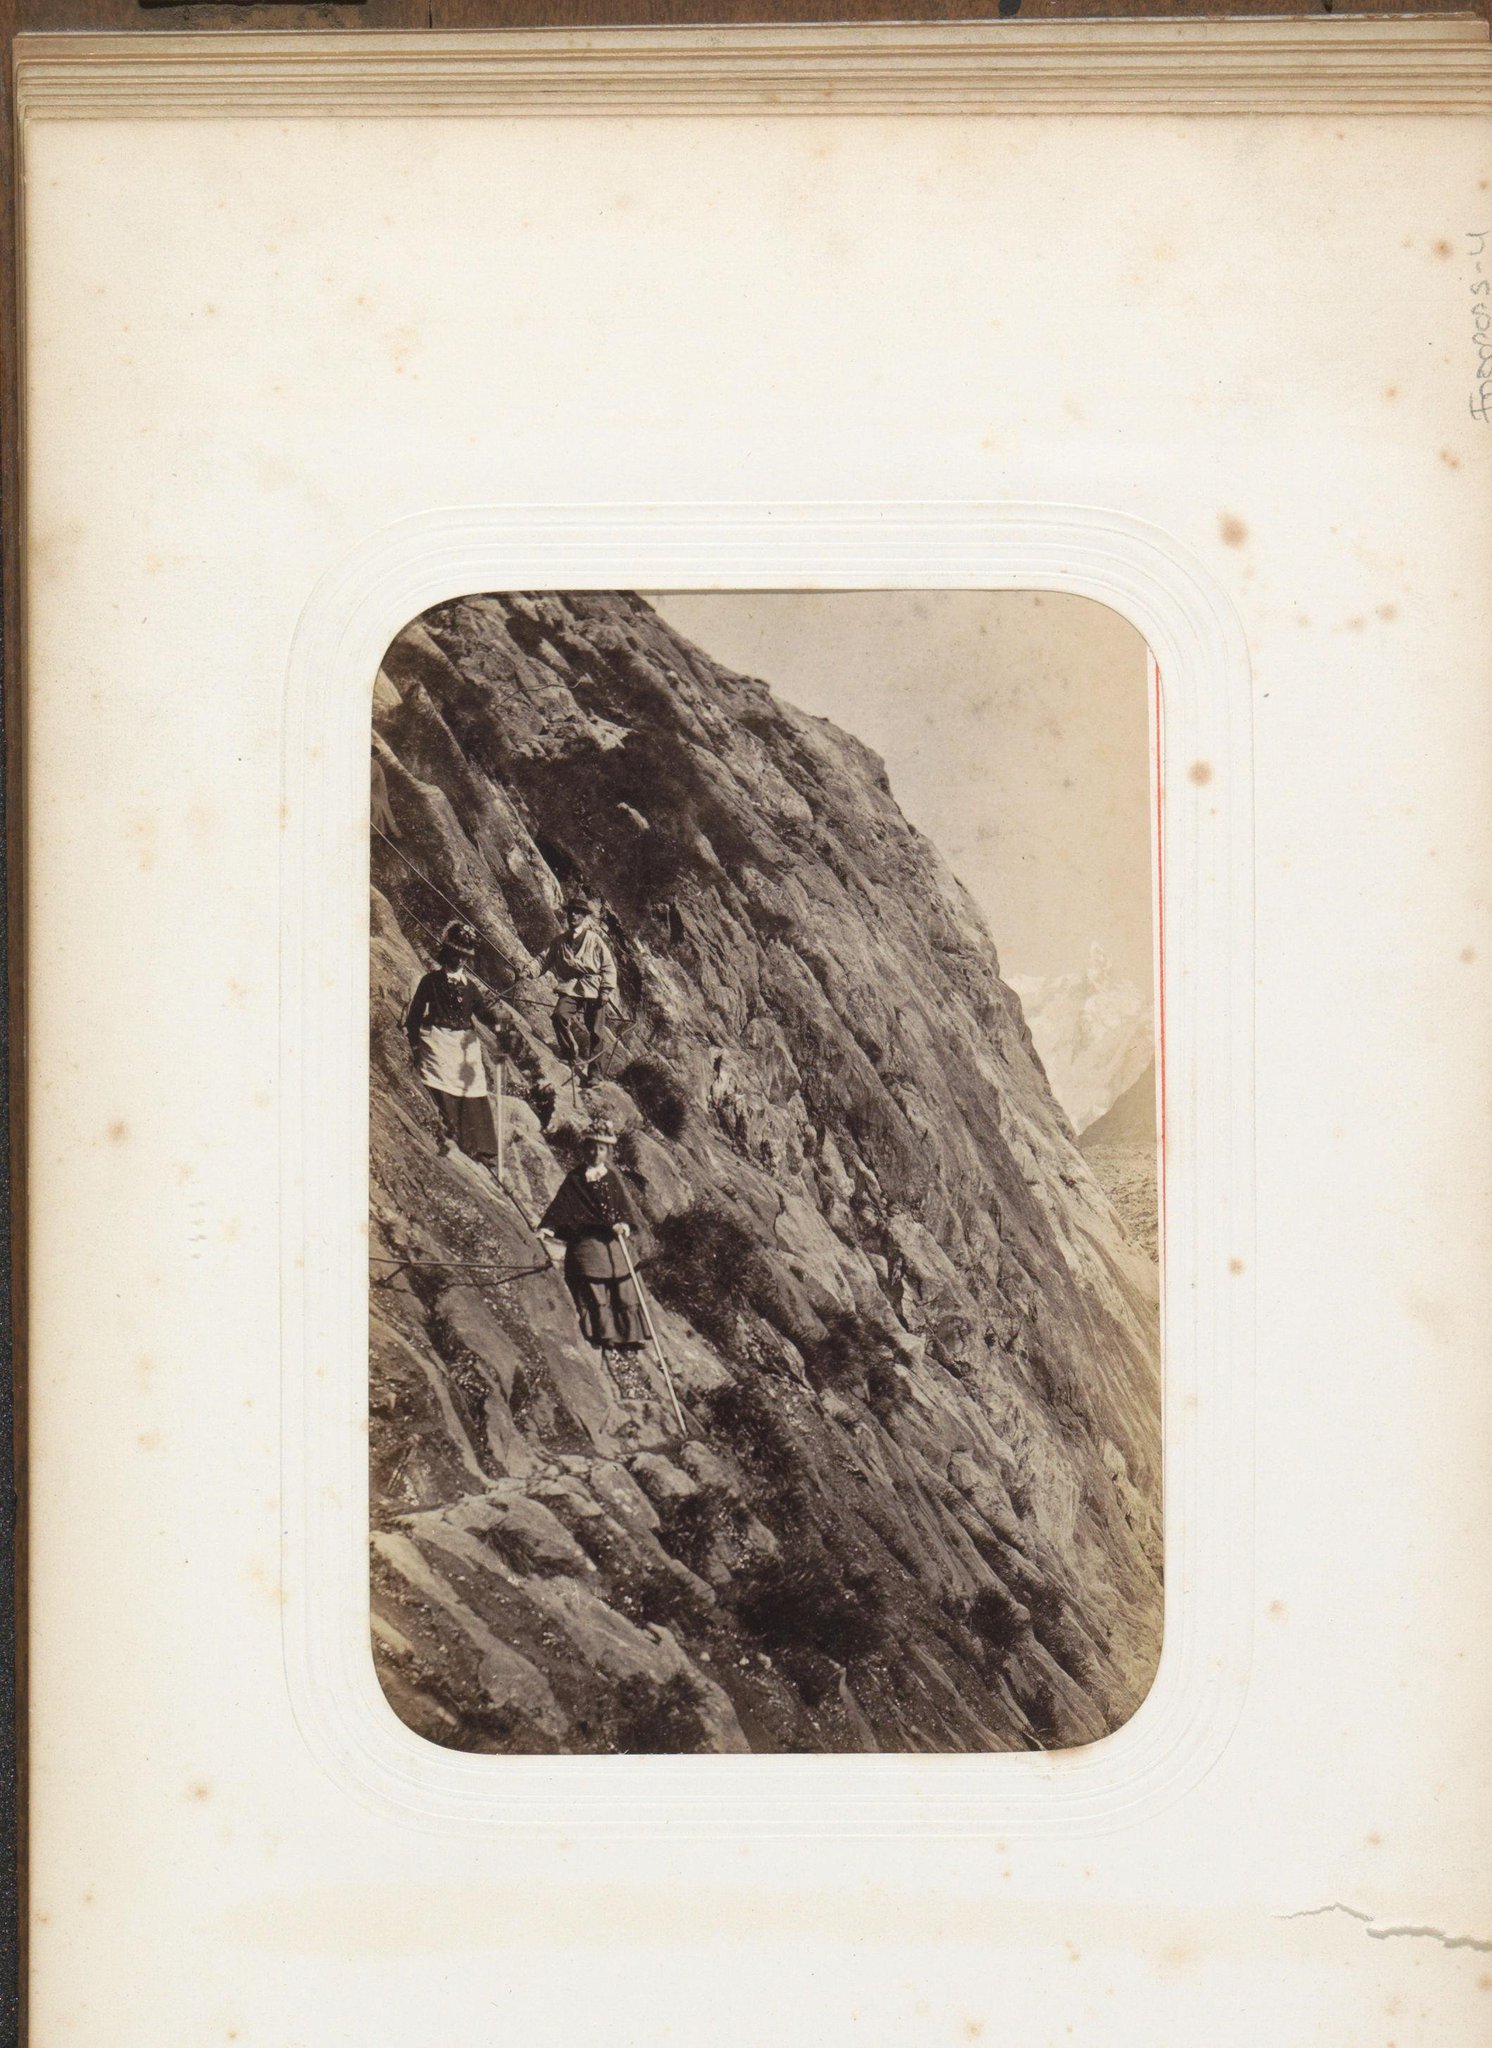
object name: photograph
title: Bergbeklimmers op Le Mauvais Pas bij Chamonix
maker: auguste garcin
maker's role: fotograaf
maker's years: 1816-1895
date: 1860-1880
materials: cardboard, paper, photographic support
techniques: albumen print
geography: chamonix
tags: mountain climbing, mountaineering, mountains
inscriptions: inscription: ‘L Mauvais Pas’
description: Onderdeel van Reisalbum met bezienswaardigheden in de Zwitserse Alpen.